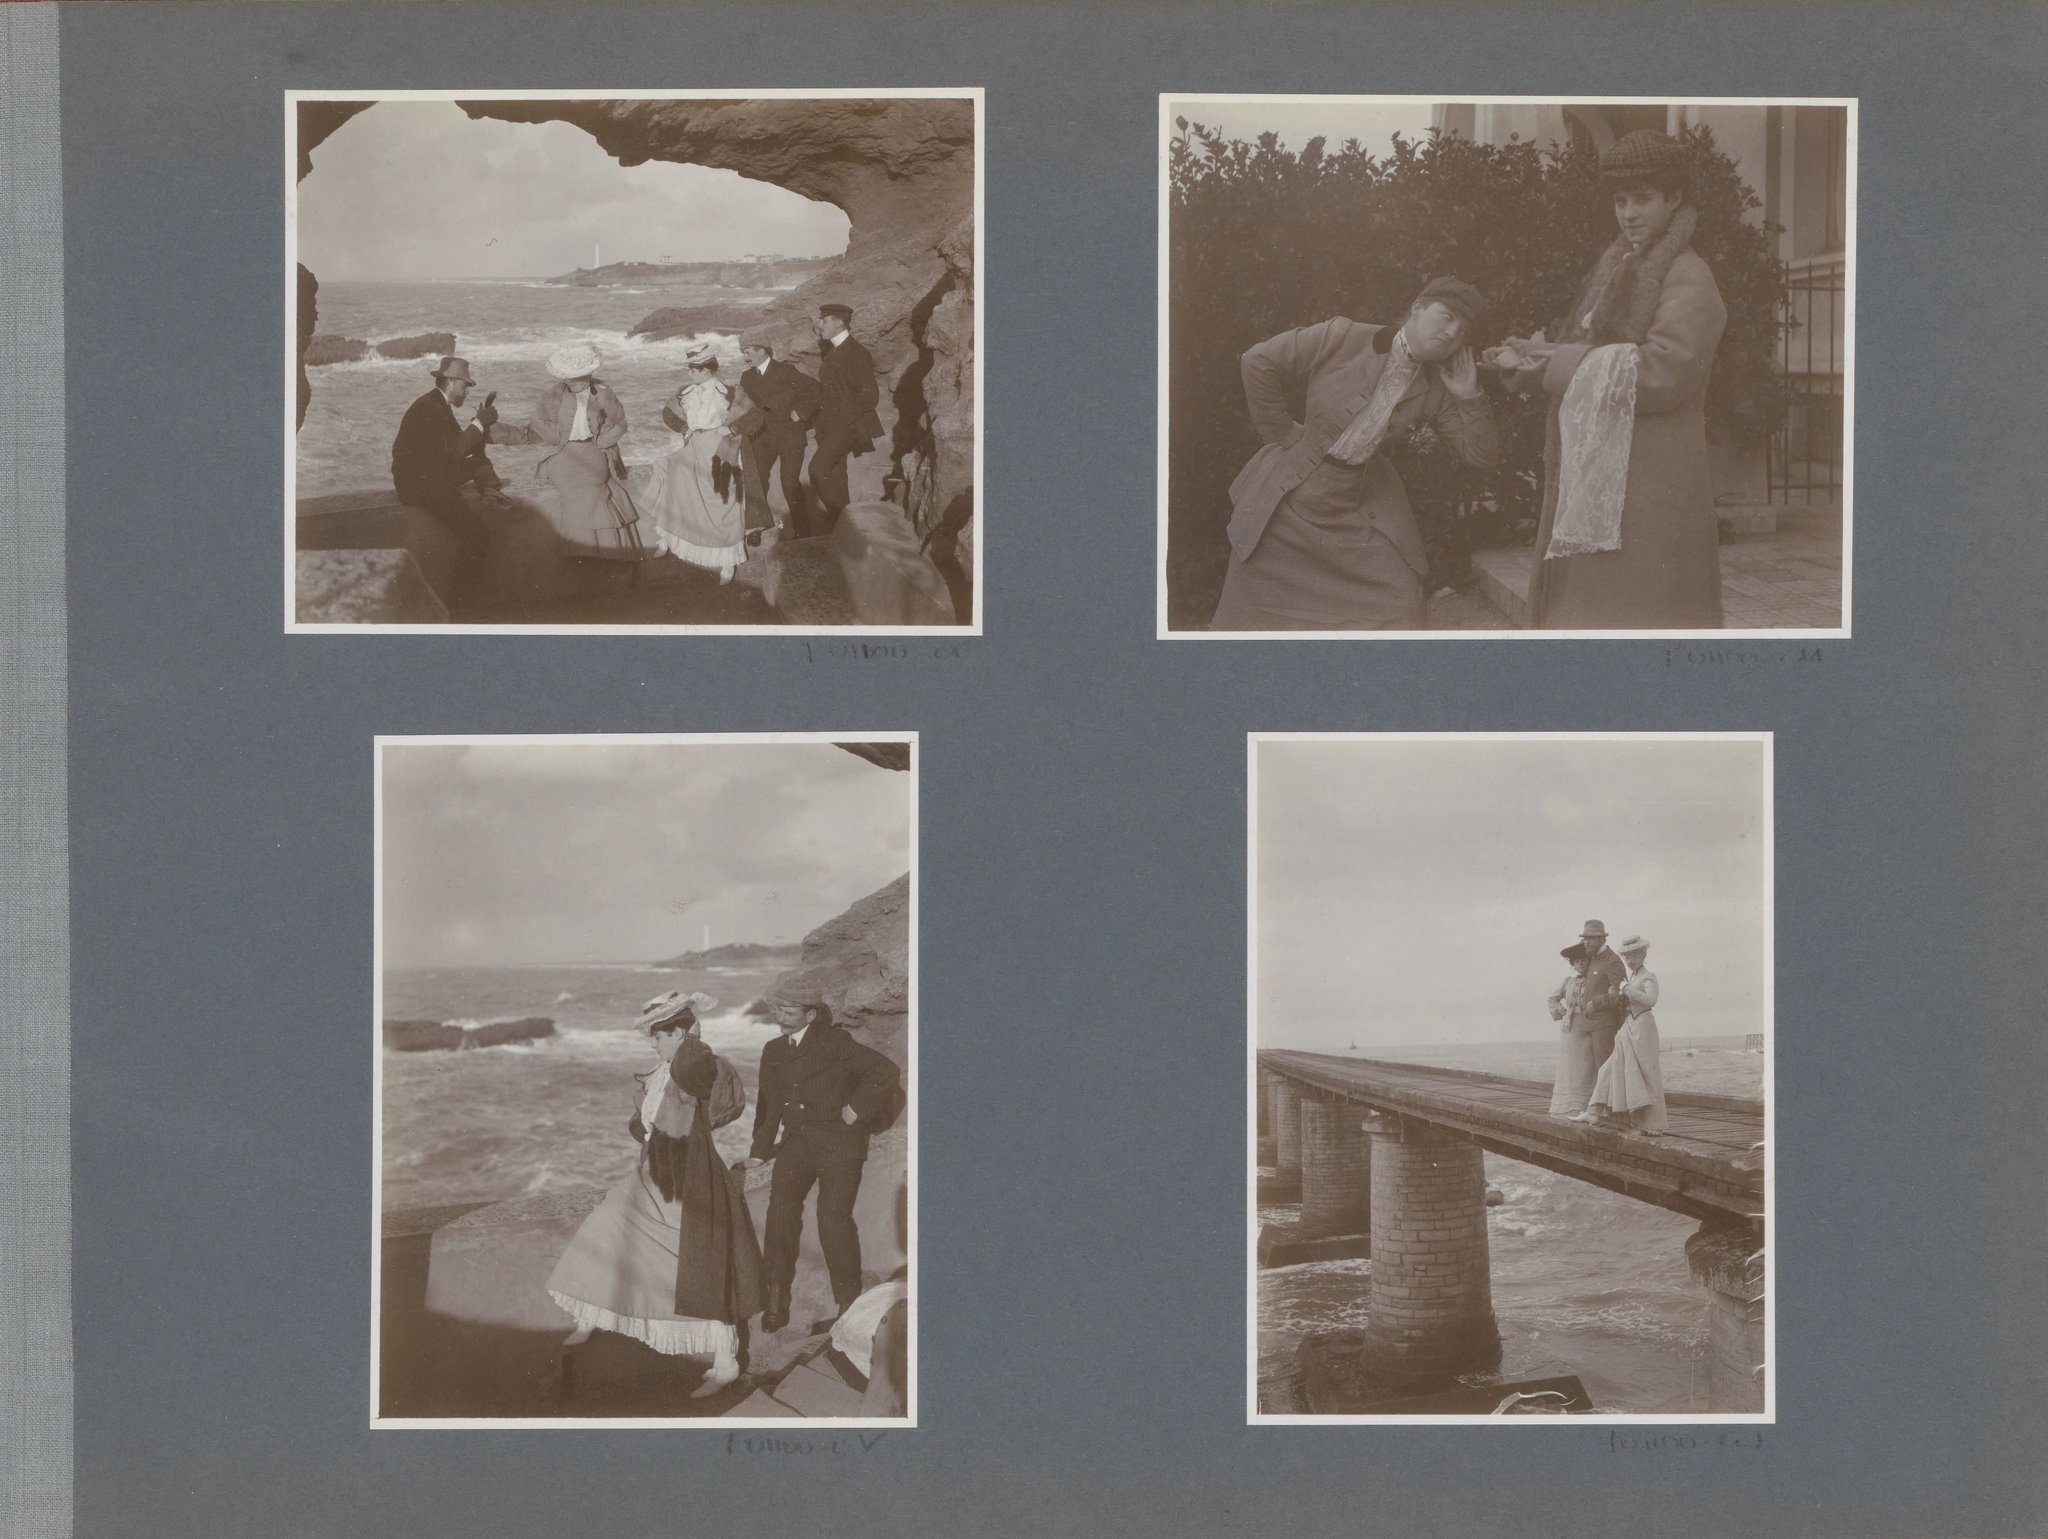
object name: photograph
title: Vrouw met sjaal over de arm, andere vrouw in luisterende houding, Frankrijk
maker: Anonymous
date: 1902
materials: paper, photographic support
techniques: daylight paper print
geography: france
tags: hearing, listening (one of the five senses), adult woman, france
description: Onderdeel van Fotoalbum van een legeroefening in Zuidwest-Frankrijk in 1902.